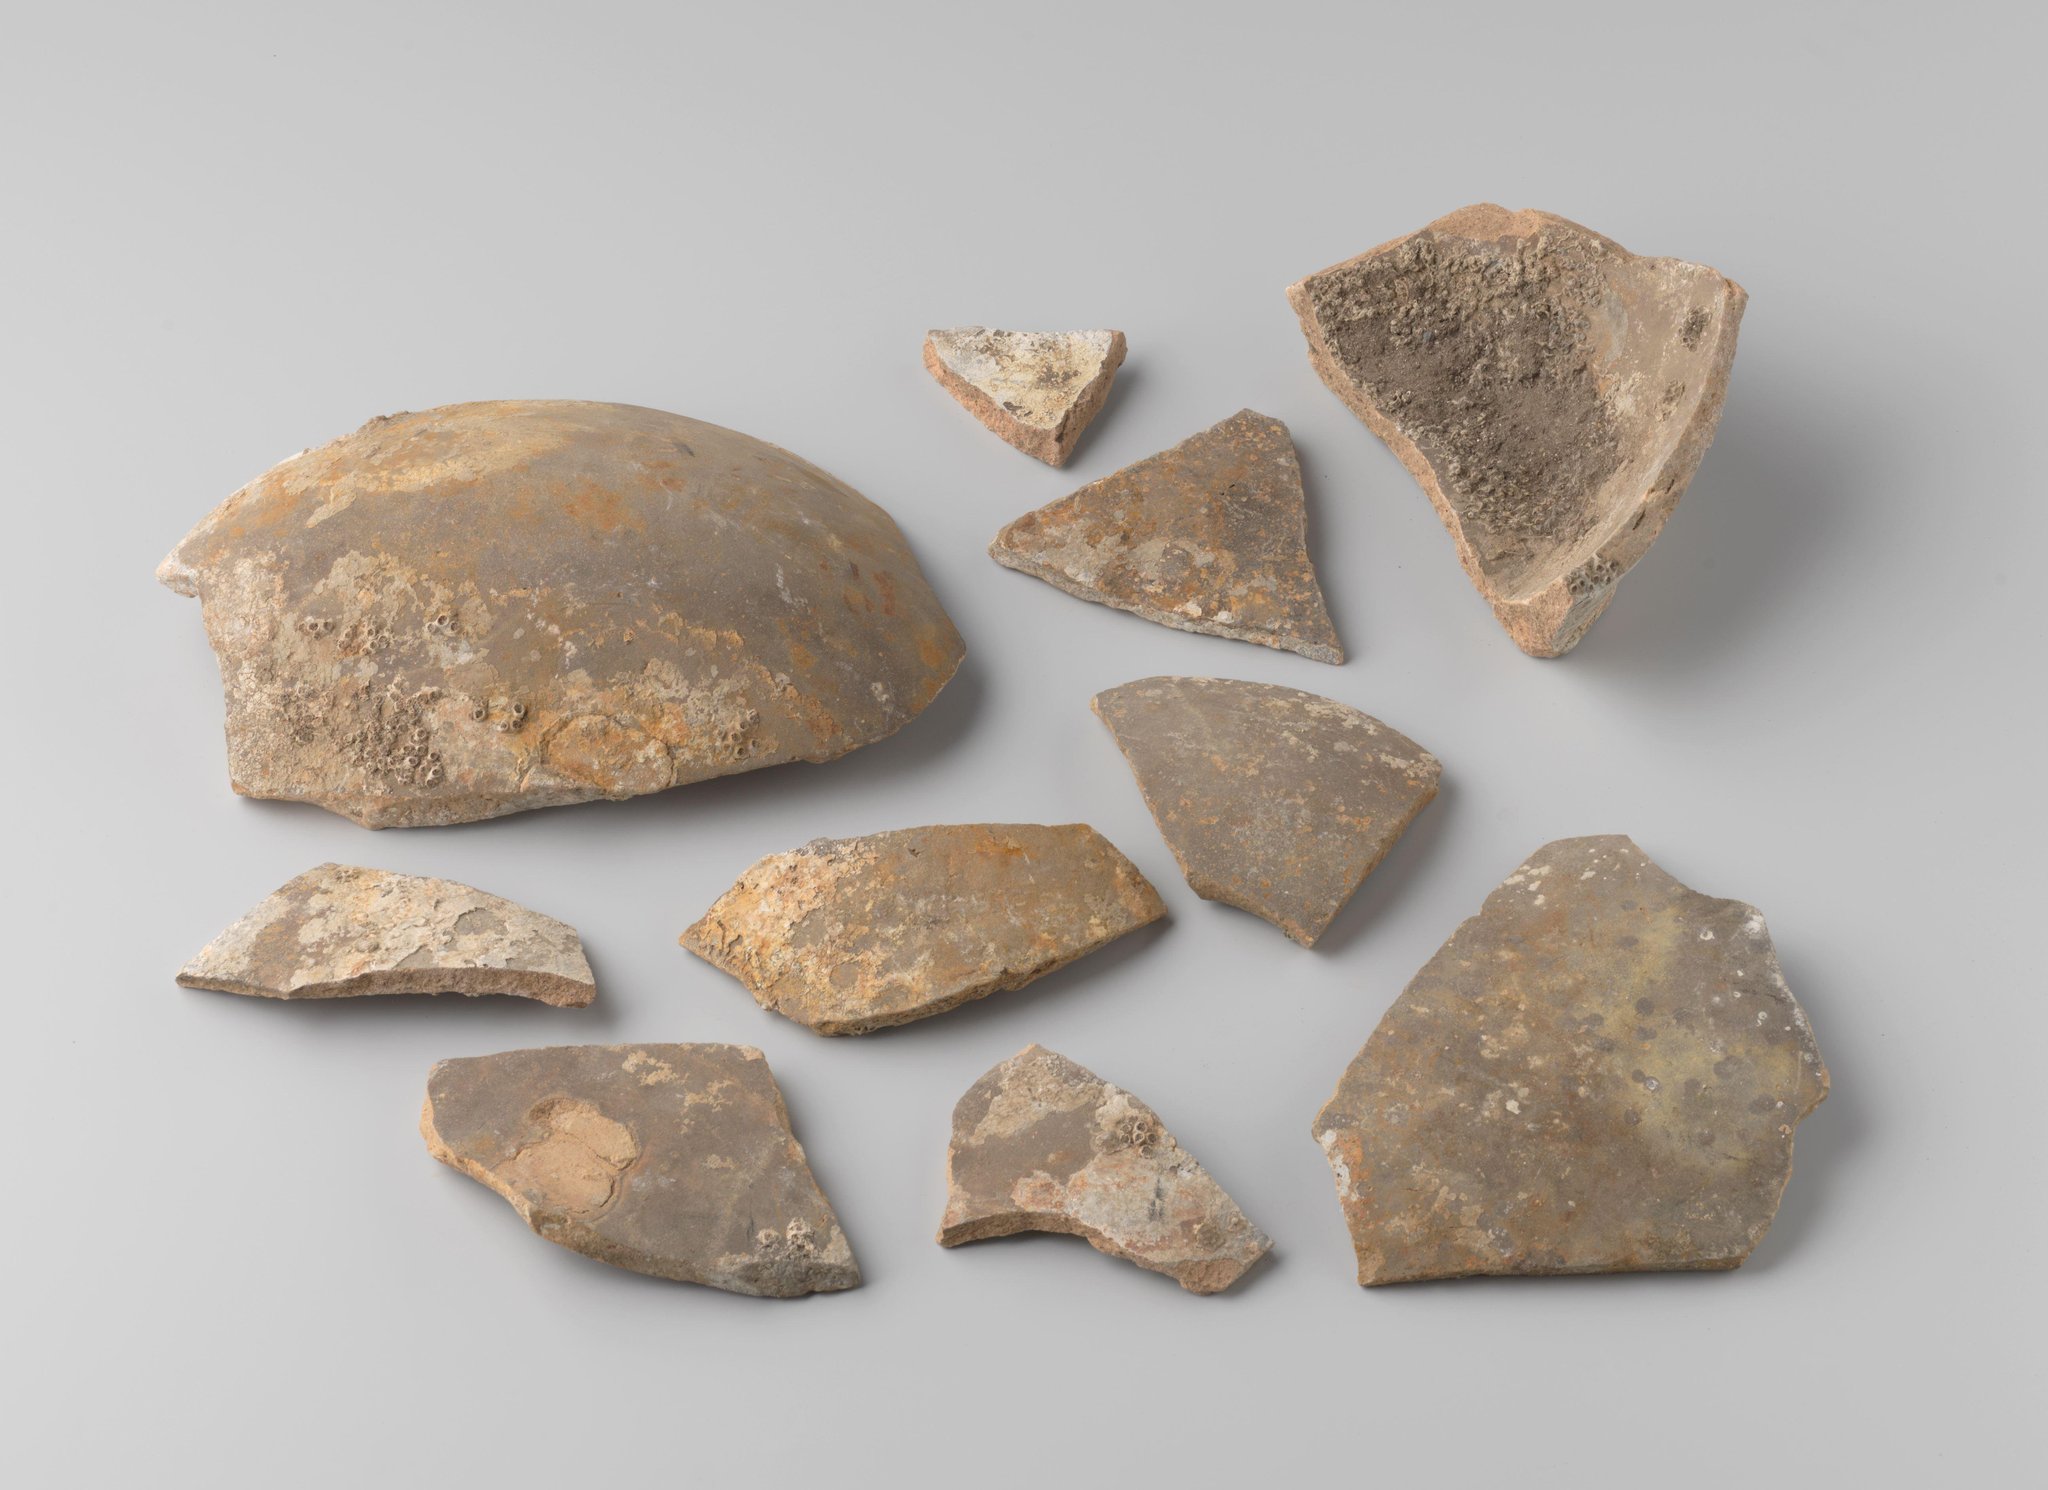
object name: martavaan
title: Scherven van martavanen uit V.O.C.-schip de 'Witte Leeuw'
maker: Anonymous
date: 1613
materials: porcelain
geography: southeast asia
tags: verenigde oostindische compagnie, sint-helena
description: Scherven van martavanen uit V.O.C.-schip de 'Witte Leeuw'.